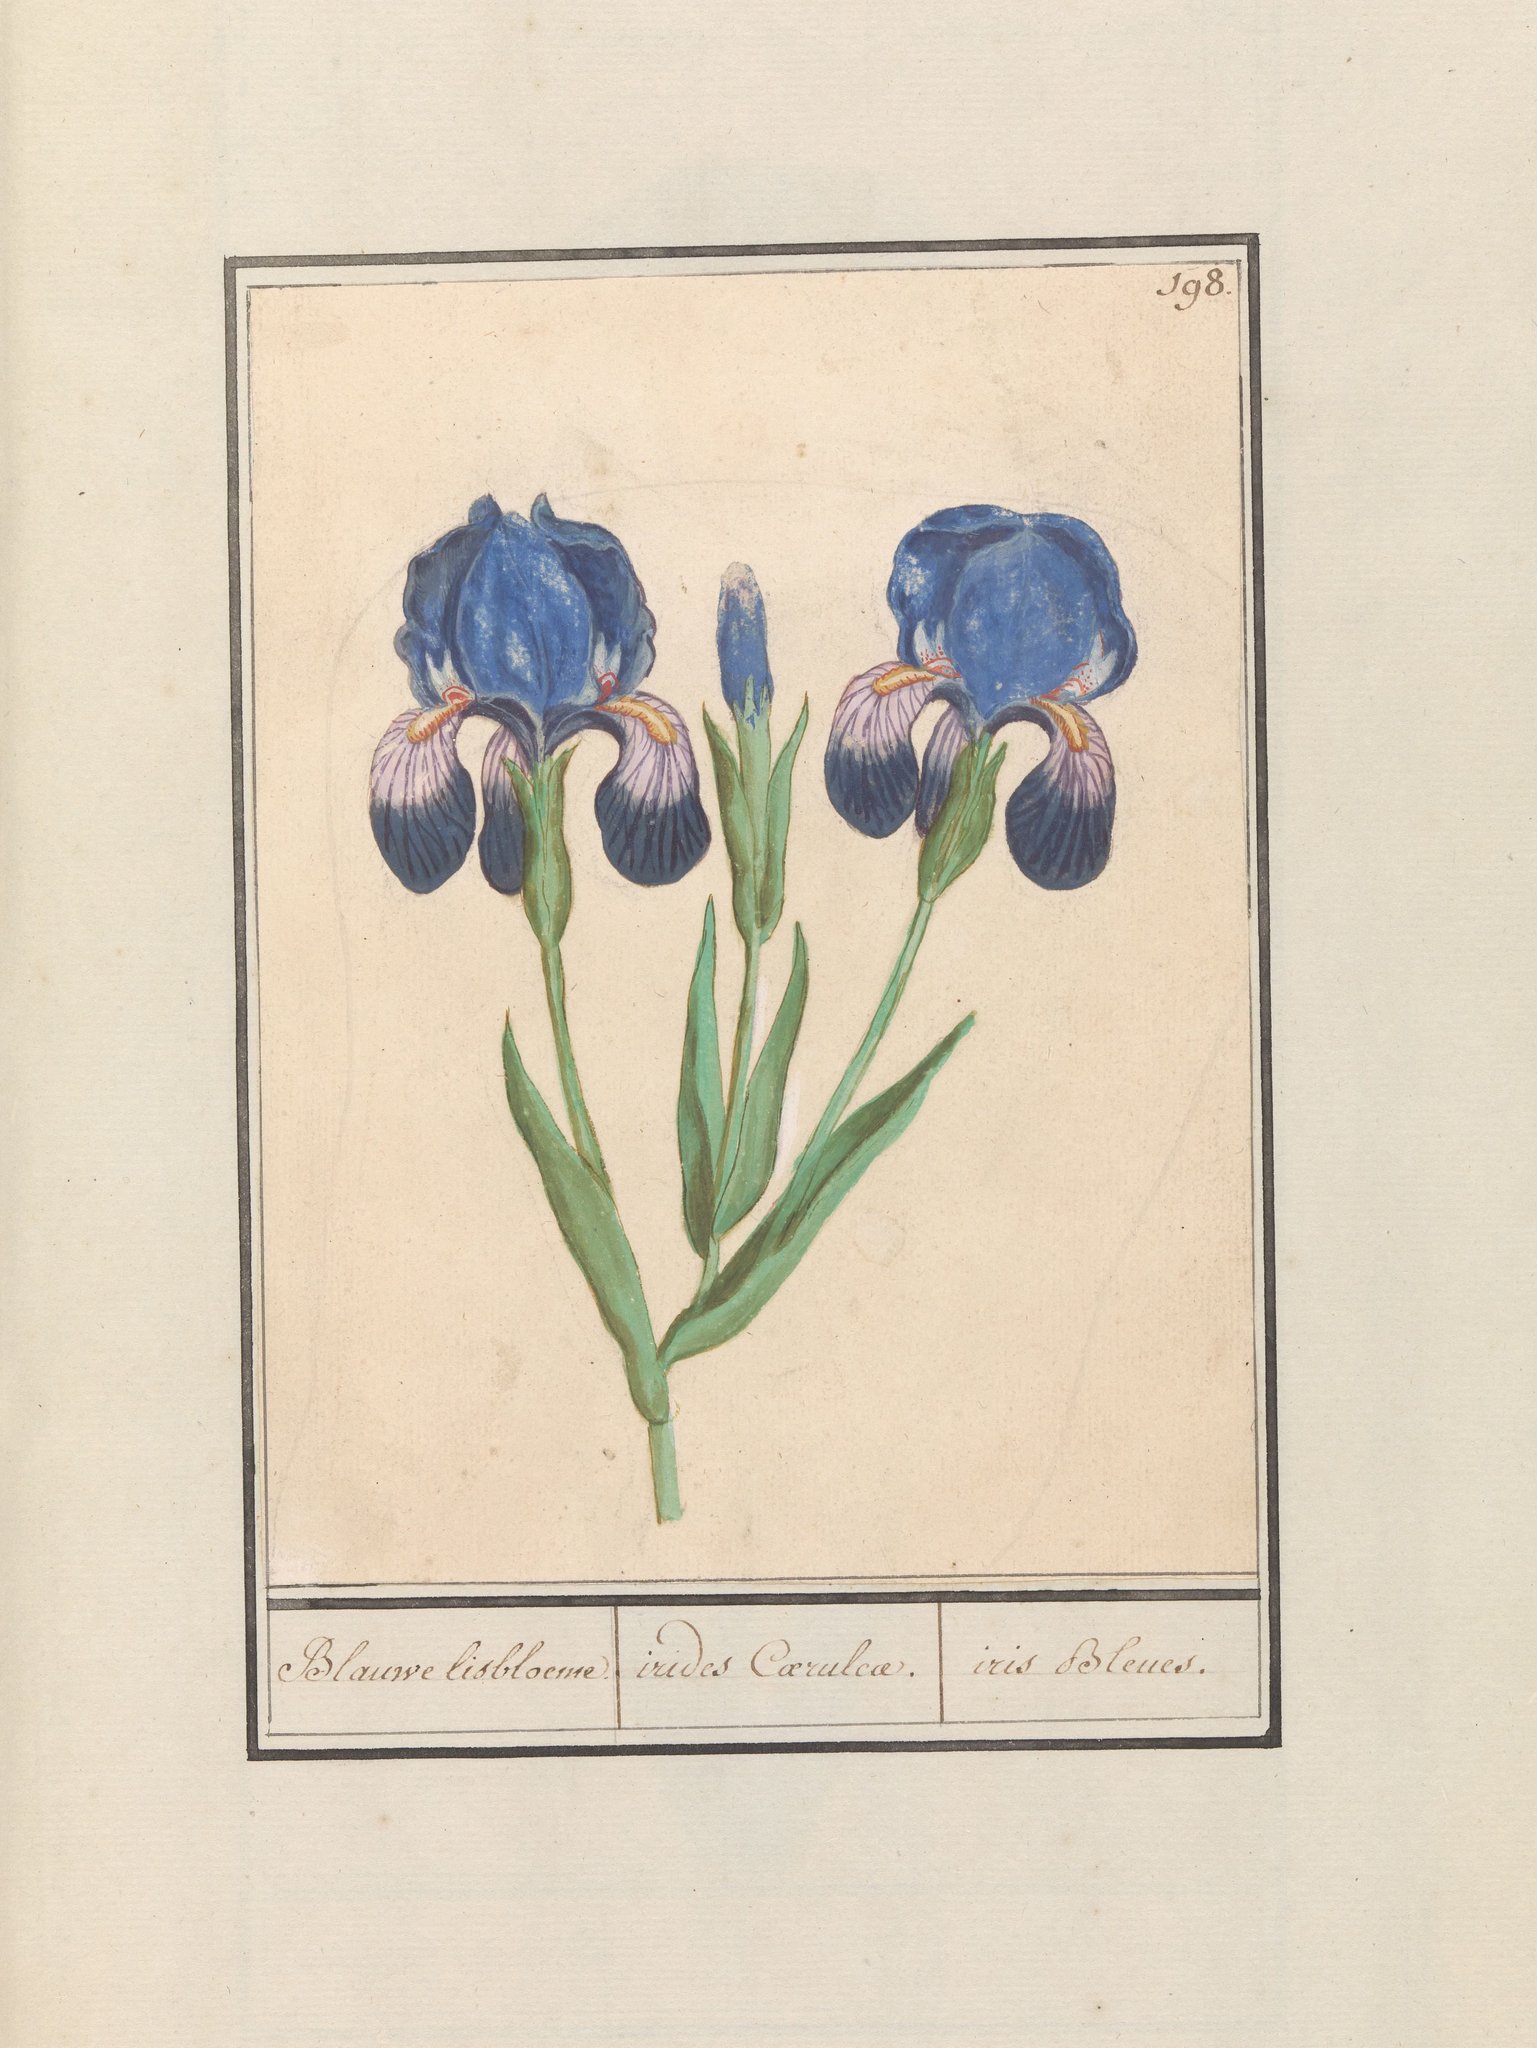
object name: drawing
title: Paarse iris (Iris germanica)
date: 1596-1610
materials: chalk, paint, paper, watercolor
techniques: brush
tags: flowers: iris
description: Paarse iris. Genummerd rechtsboven: 198. Onderdeel van het tweede album met tekeningen van bloemen en planten. Negende van twaalf albums met tekeningen van dieren, vogels en planten bekend rond 1600, gemaakt in opdracht van keizer Rudolf II. Met toelichting in Nederlands, Latijn en Frans.